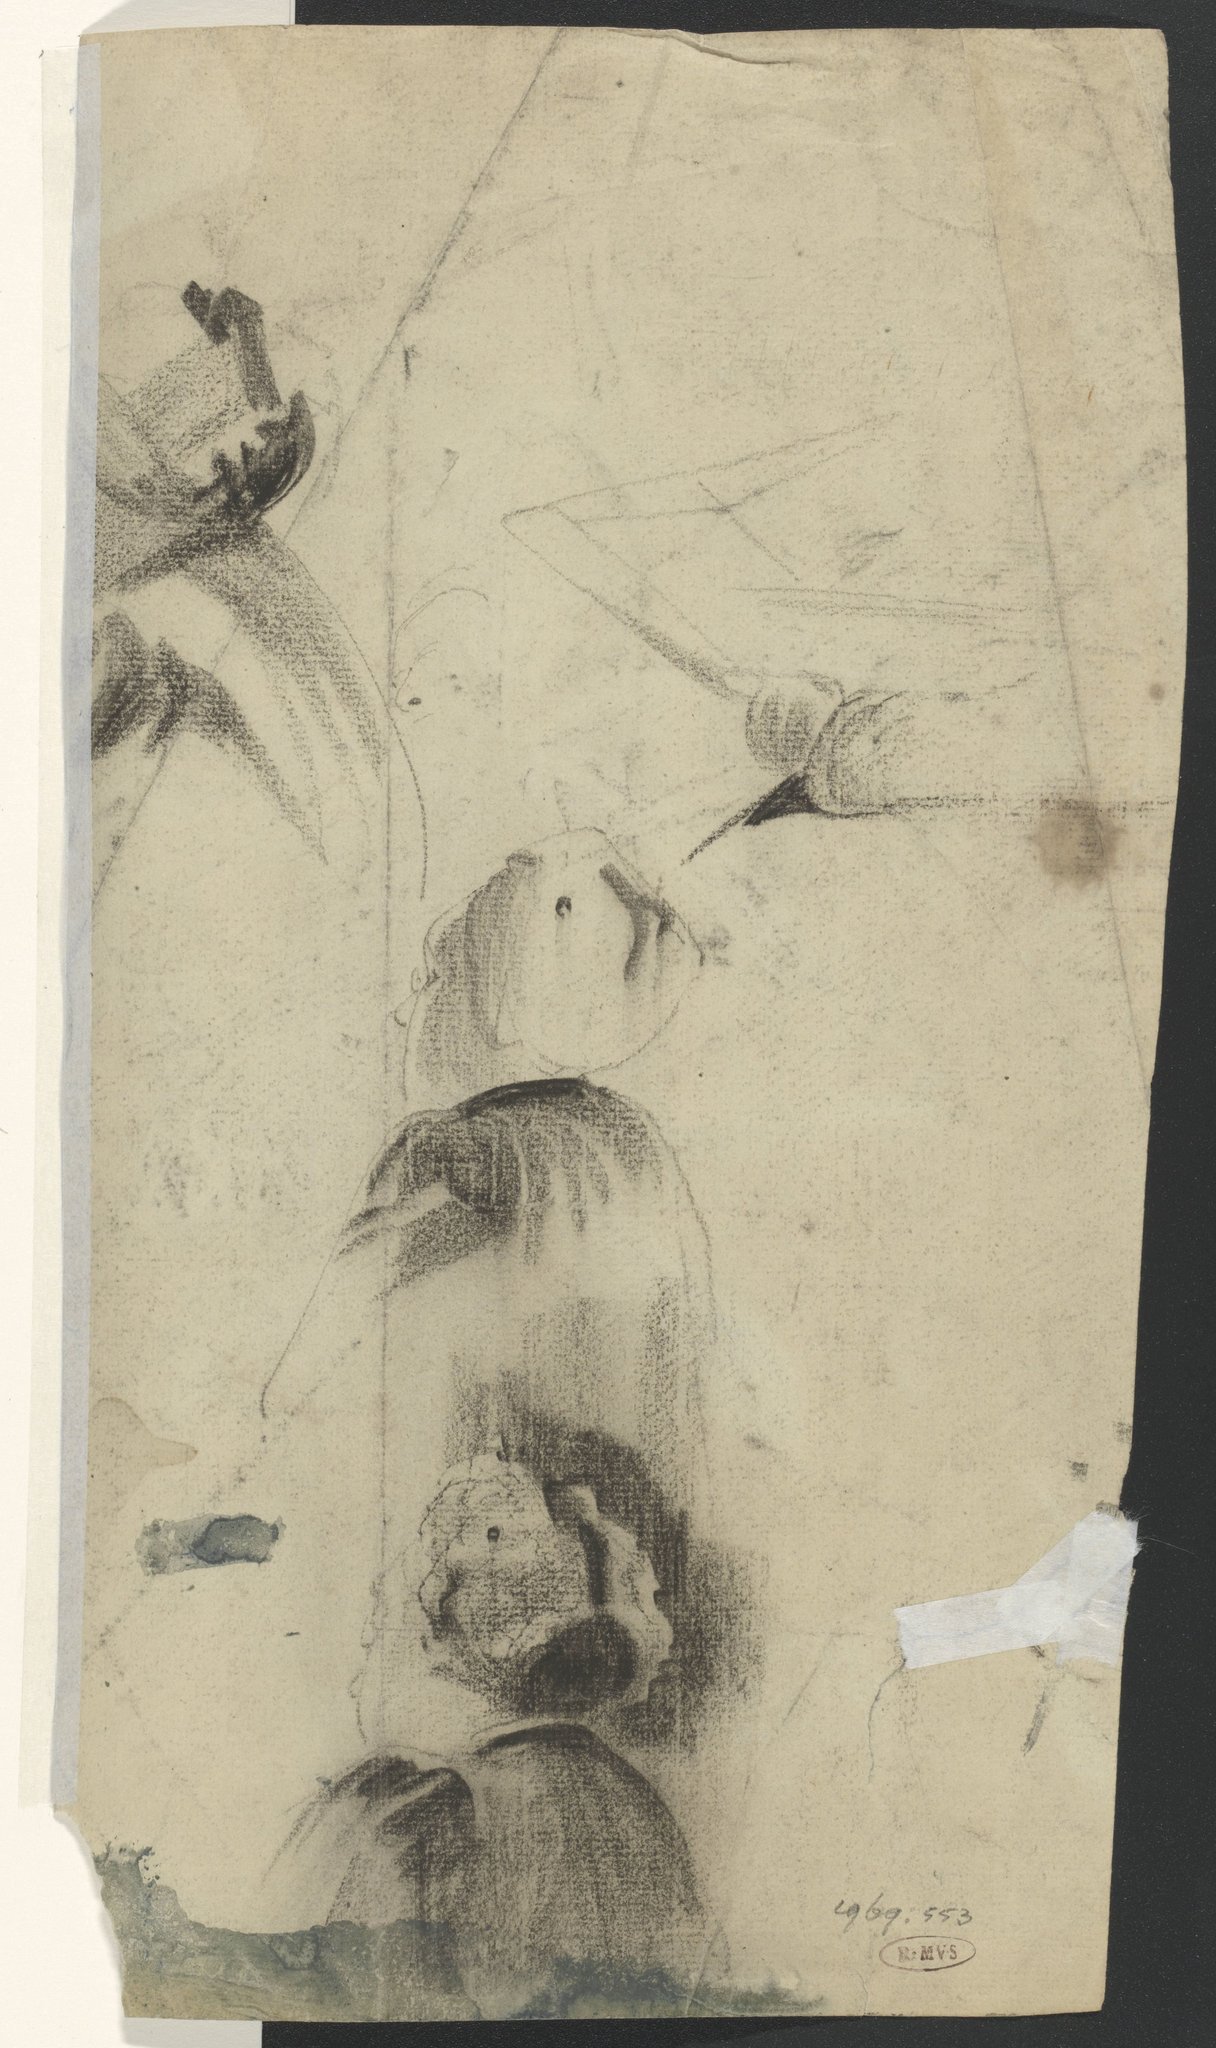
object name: drawing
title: Persoon, schuin van achteren gezien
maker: carel adolph lion cachet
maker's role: draughtsman, print maker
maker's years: 1864-1945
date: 1874-1945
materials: chalk, paper